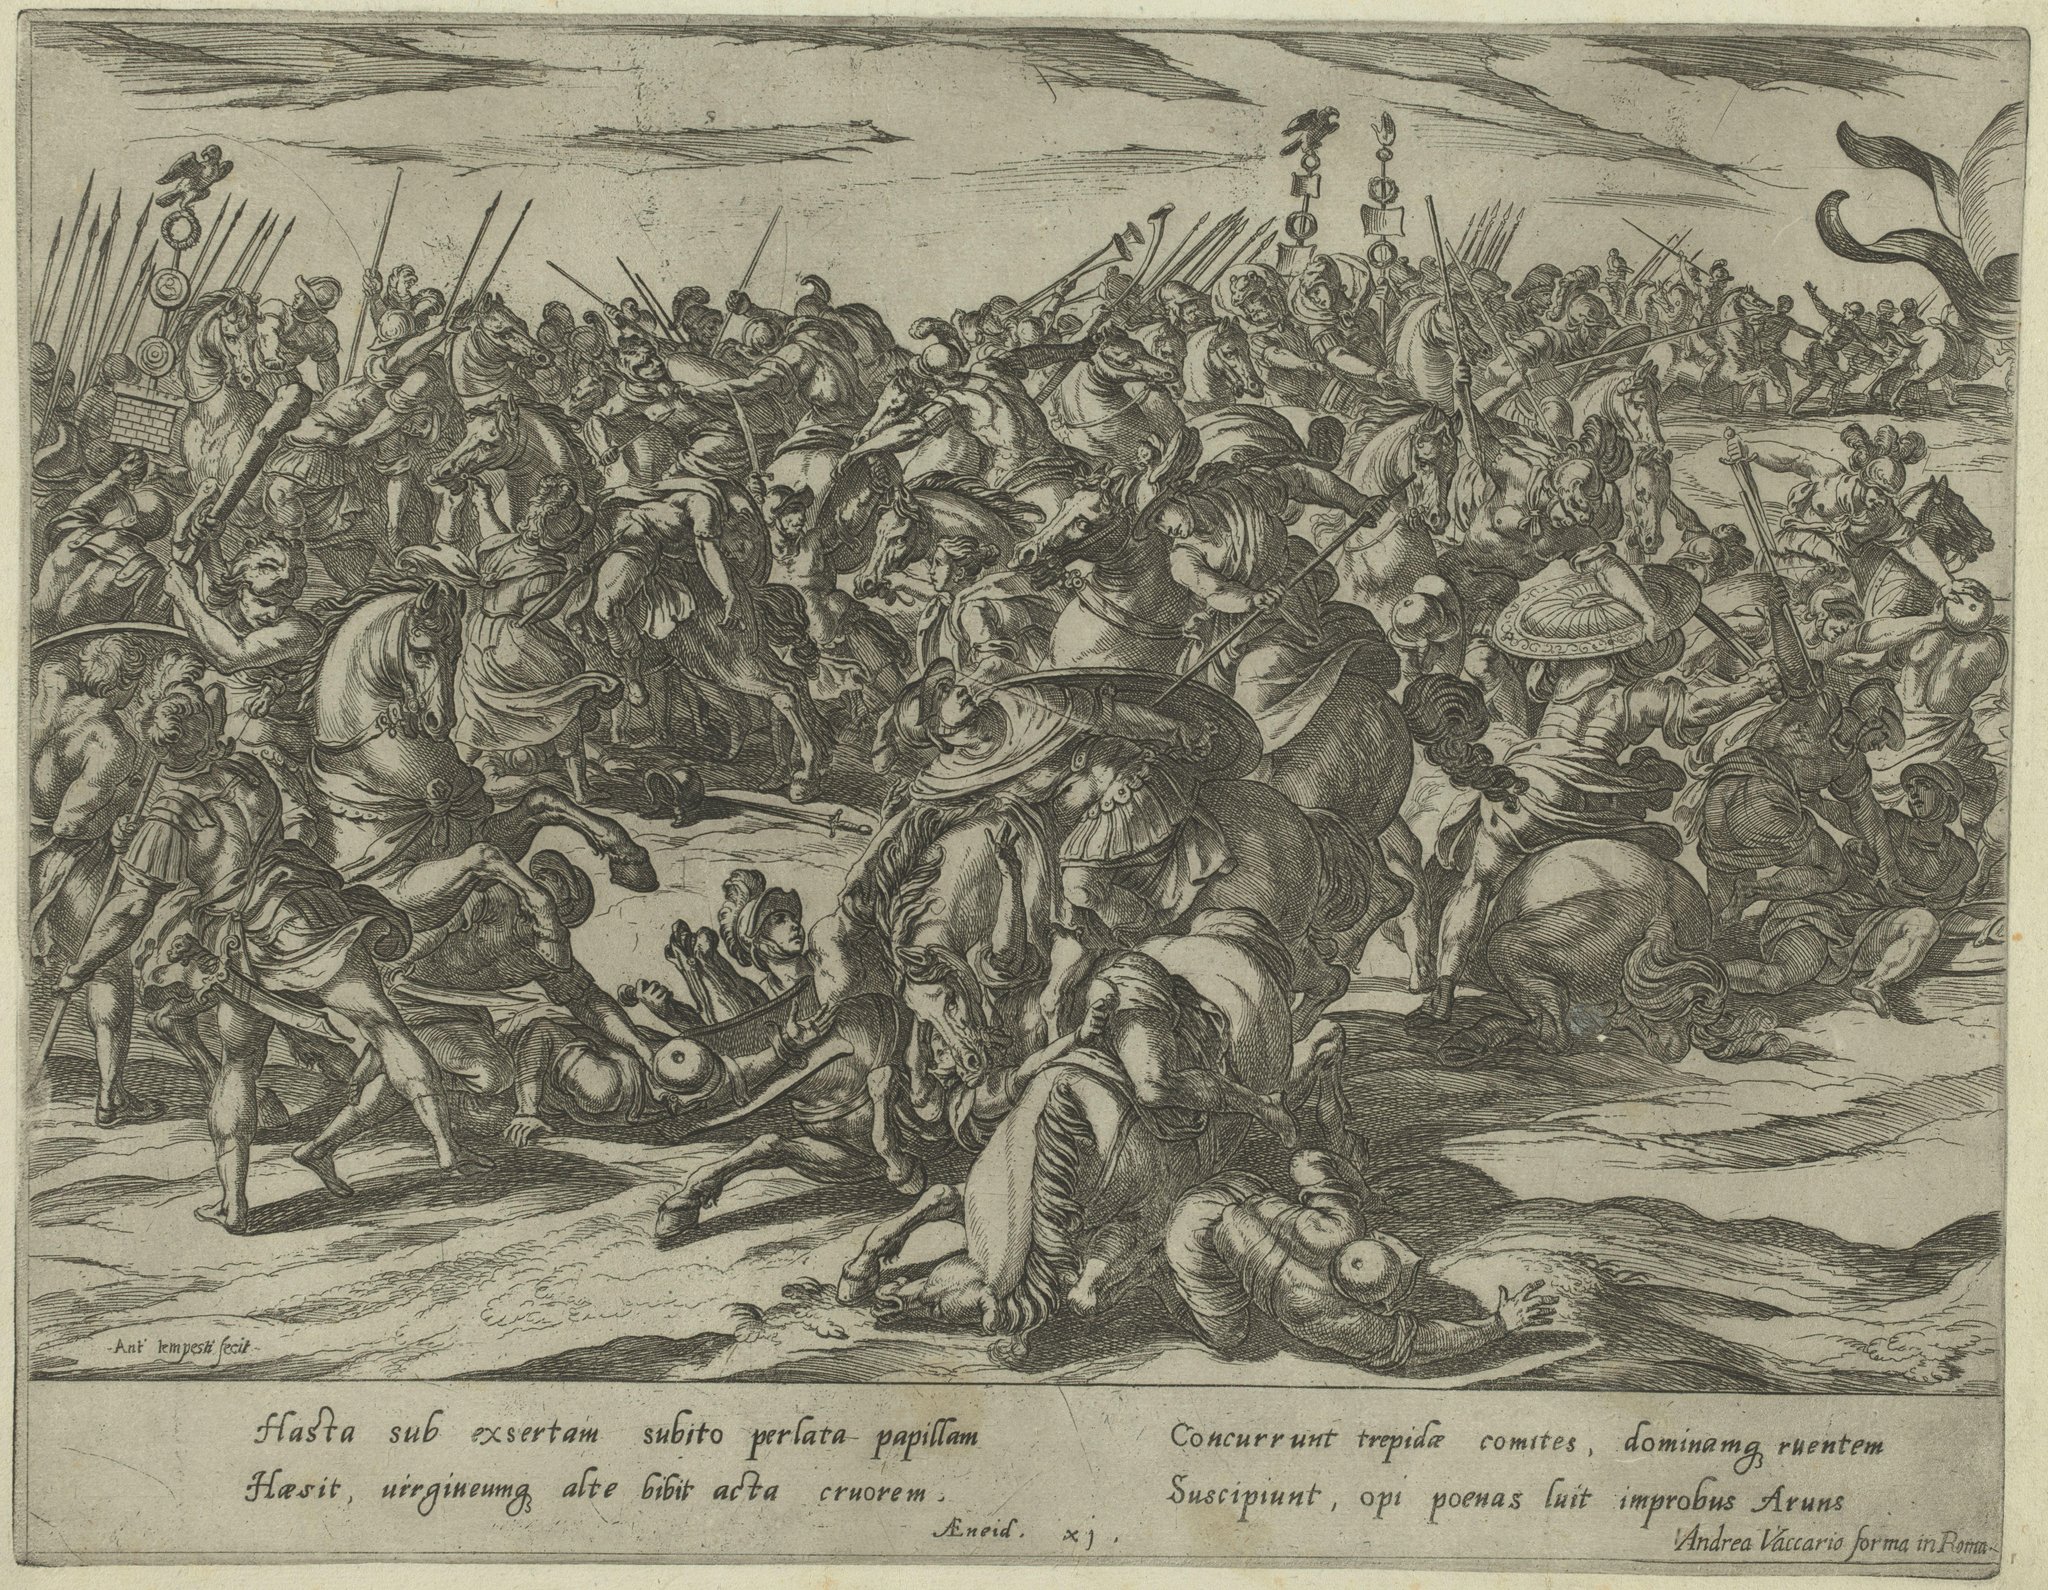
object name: print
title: De dood van Camillus in de strijd tussen Grieken en Romeinen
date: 1591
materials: paper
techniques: etching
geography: rome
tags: (story of) camilla - death, battle, the soldier; the soldier's life, warfare; military affairs (+ land forces)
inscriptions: collector's mark: Lugt 240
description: De dood van Camillus in een strijdgewoel van Griekse en Romeinse soldaten te paard. Vers in het Latijn in ondermarge.